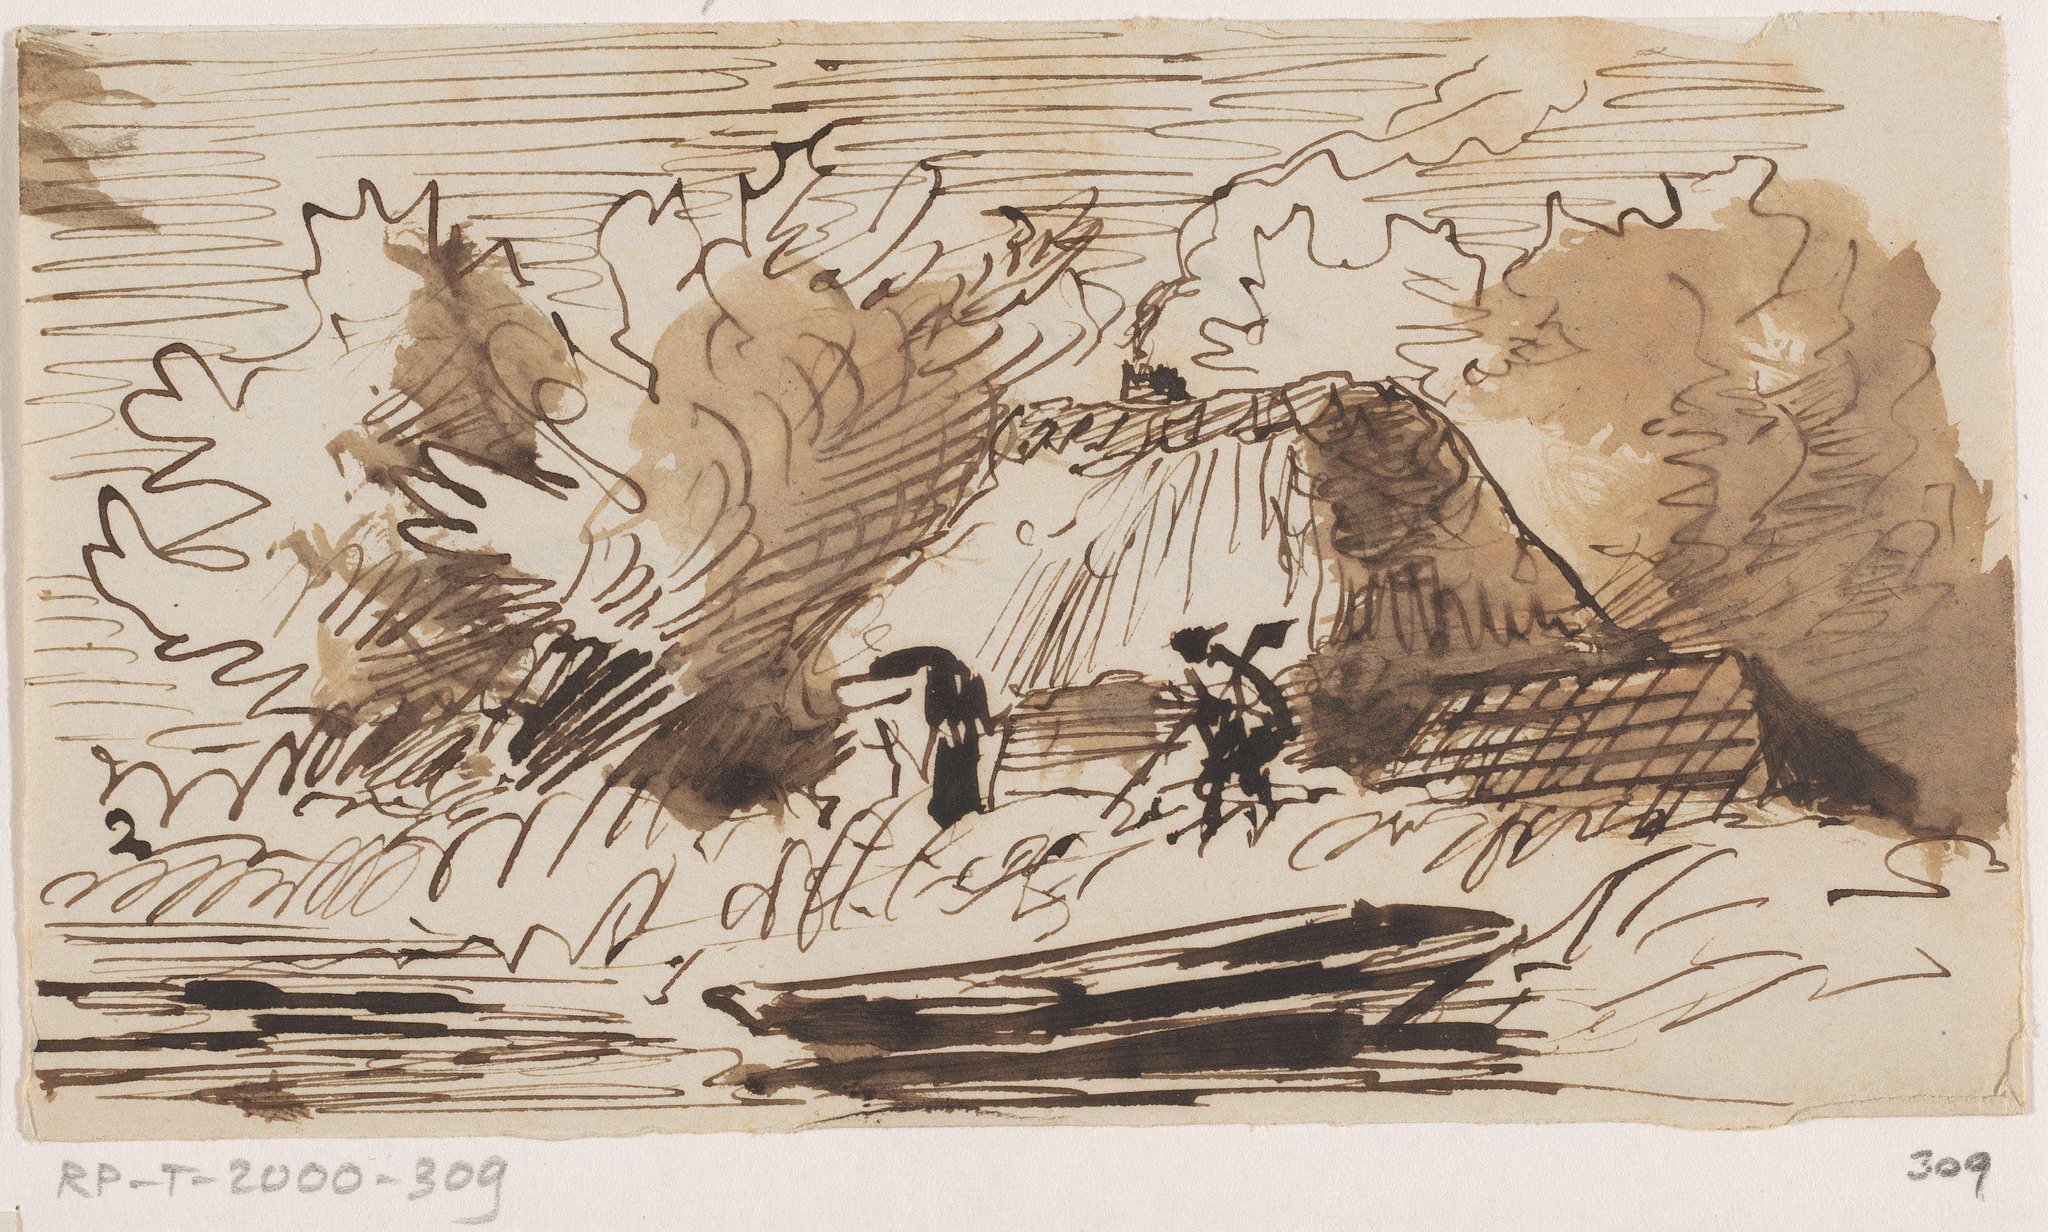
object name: drawing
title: Boerderij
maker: johannes tavenraat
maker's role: draughtsman, painter, print maker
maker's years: 1809-1881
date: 1840-1880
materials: ink, paper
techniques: brush, pen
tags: farm (building)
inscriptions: collector's mark: Lugt 2228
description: Boerderij aan het water. Getekend op een deel van een envelop of brief gericht aan 'den heeren de erve Tavenraat'.